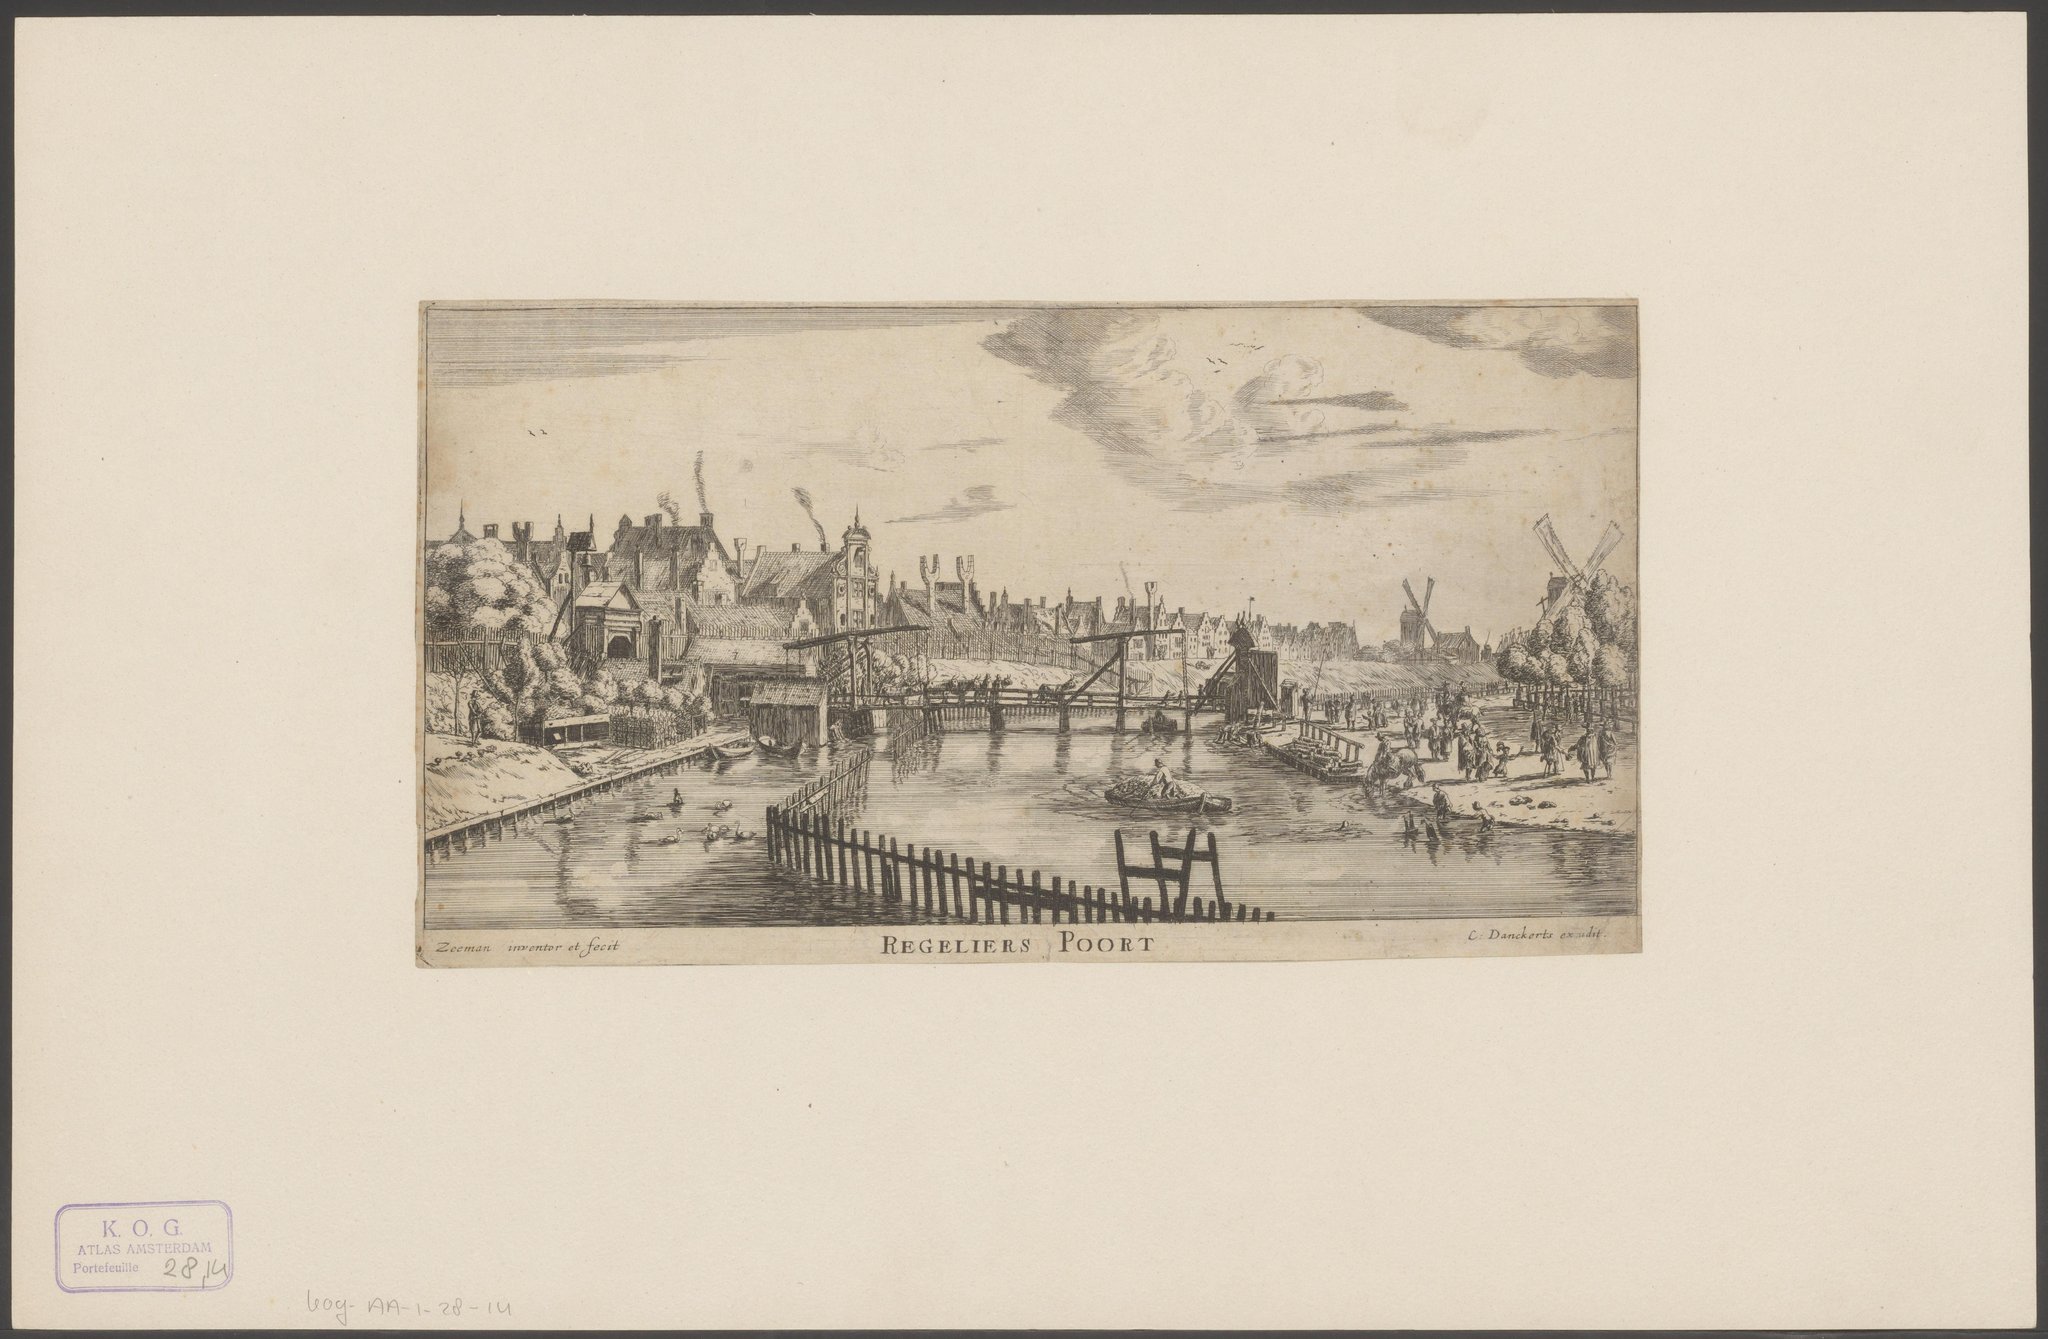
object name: print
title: Regeliers Poort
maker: reinier nooms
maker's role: draughtsman, painter, print maker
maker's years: 1623-1664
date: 1654-1701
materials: paper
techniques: drypoint, etching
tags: bridge, city-gate, canal (+ landscape with figures, staffage)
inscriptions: collector's mark: Lugt 1641b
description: Gezicht op de Tweede Regulierspoort en de bijhorende brug te Amsterdam, gezien van buiten de stad. Op de brug verschillende figuren en vee. Op de oever vele mensen. Deze in 1587 gebouwde houten stadspoort werd in 1654 afgebroken en vervangen door de stenen Derde Regulierspoort, die in 1655 werd voltooid. Onderdeel van een prentserie van Amsterdamse stadspoorten. Onderwerpsrubriek binnen de Atlas Amsterdam: Poorten, verzamelbladen, B. Regulierspoort(en).